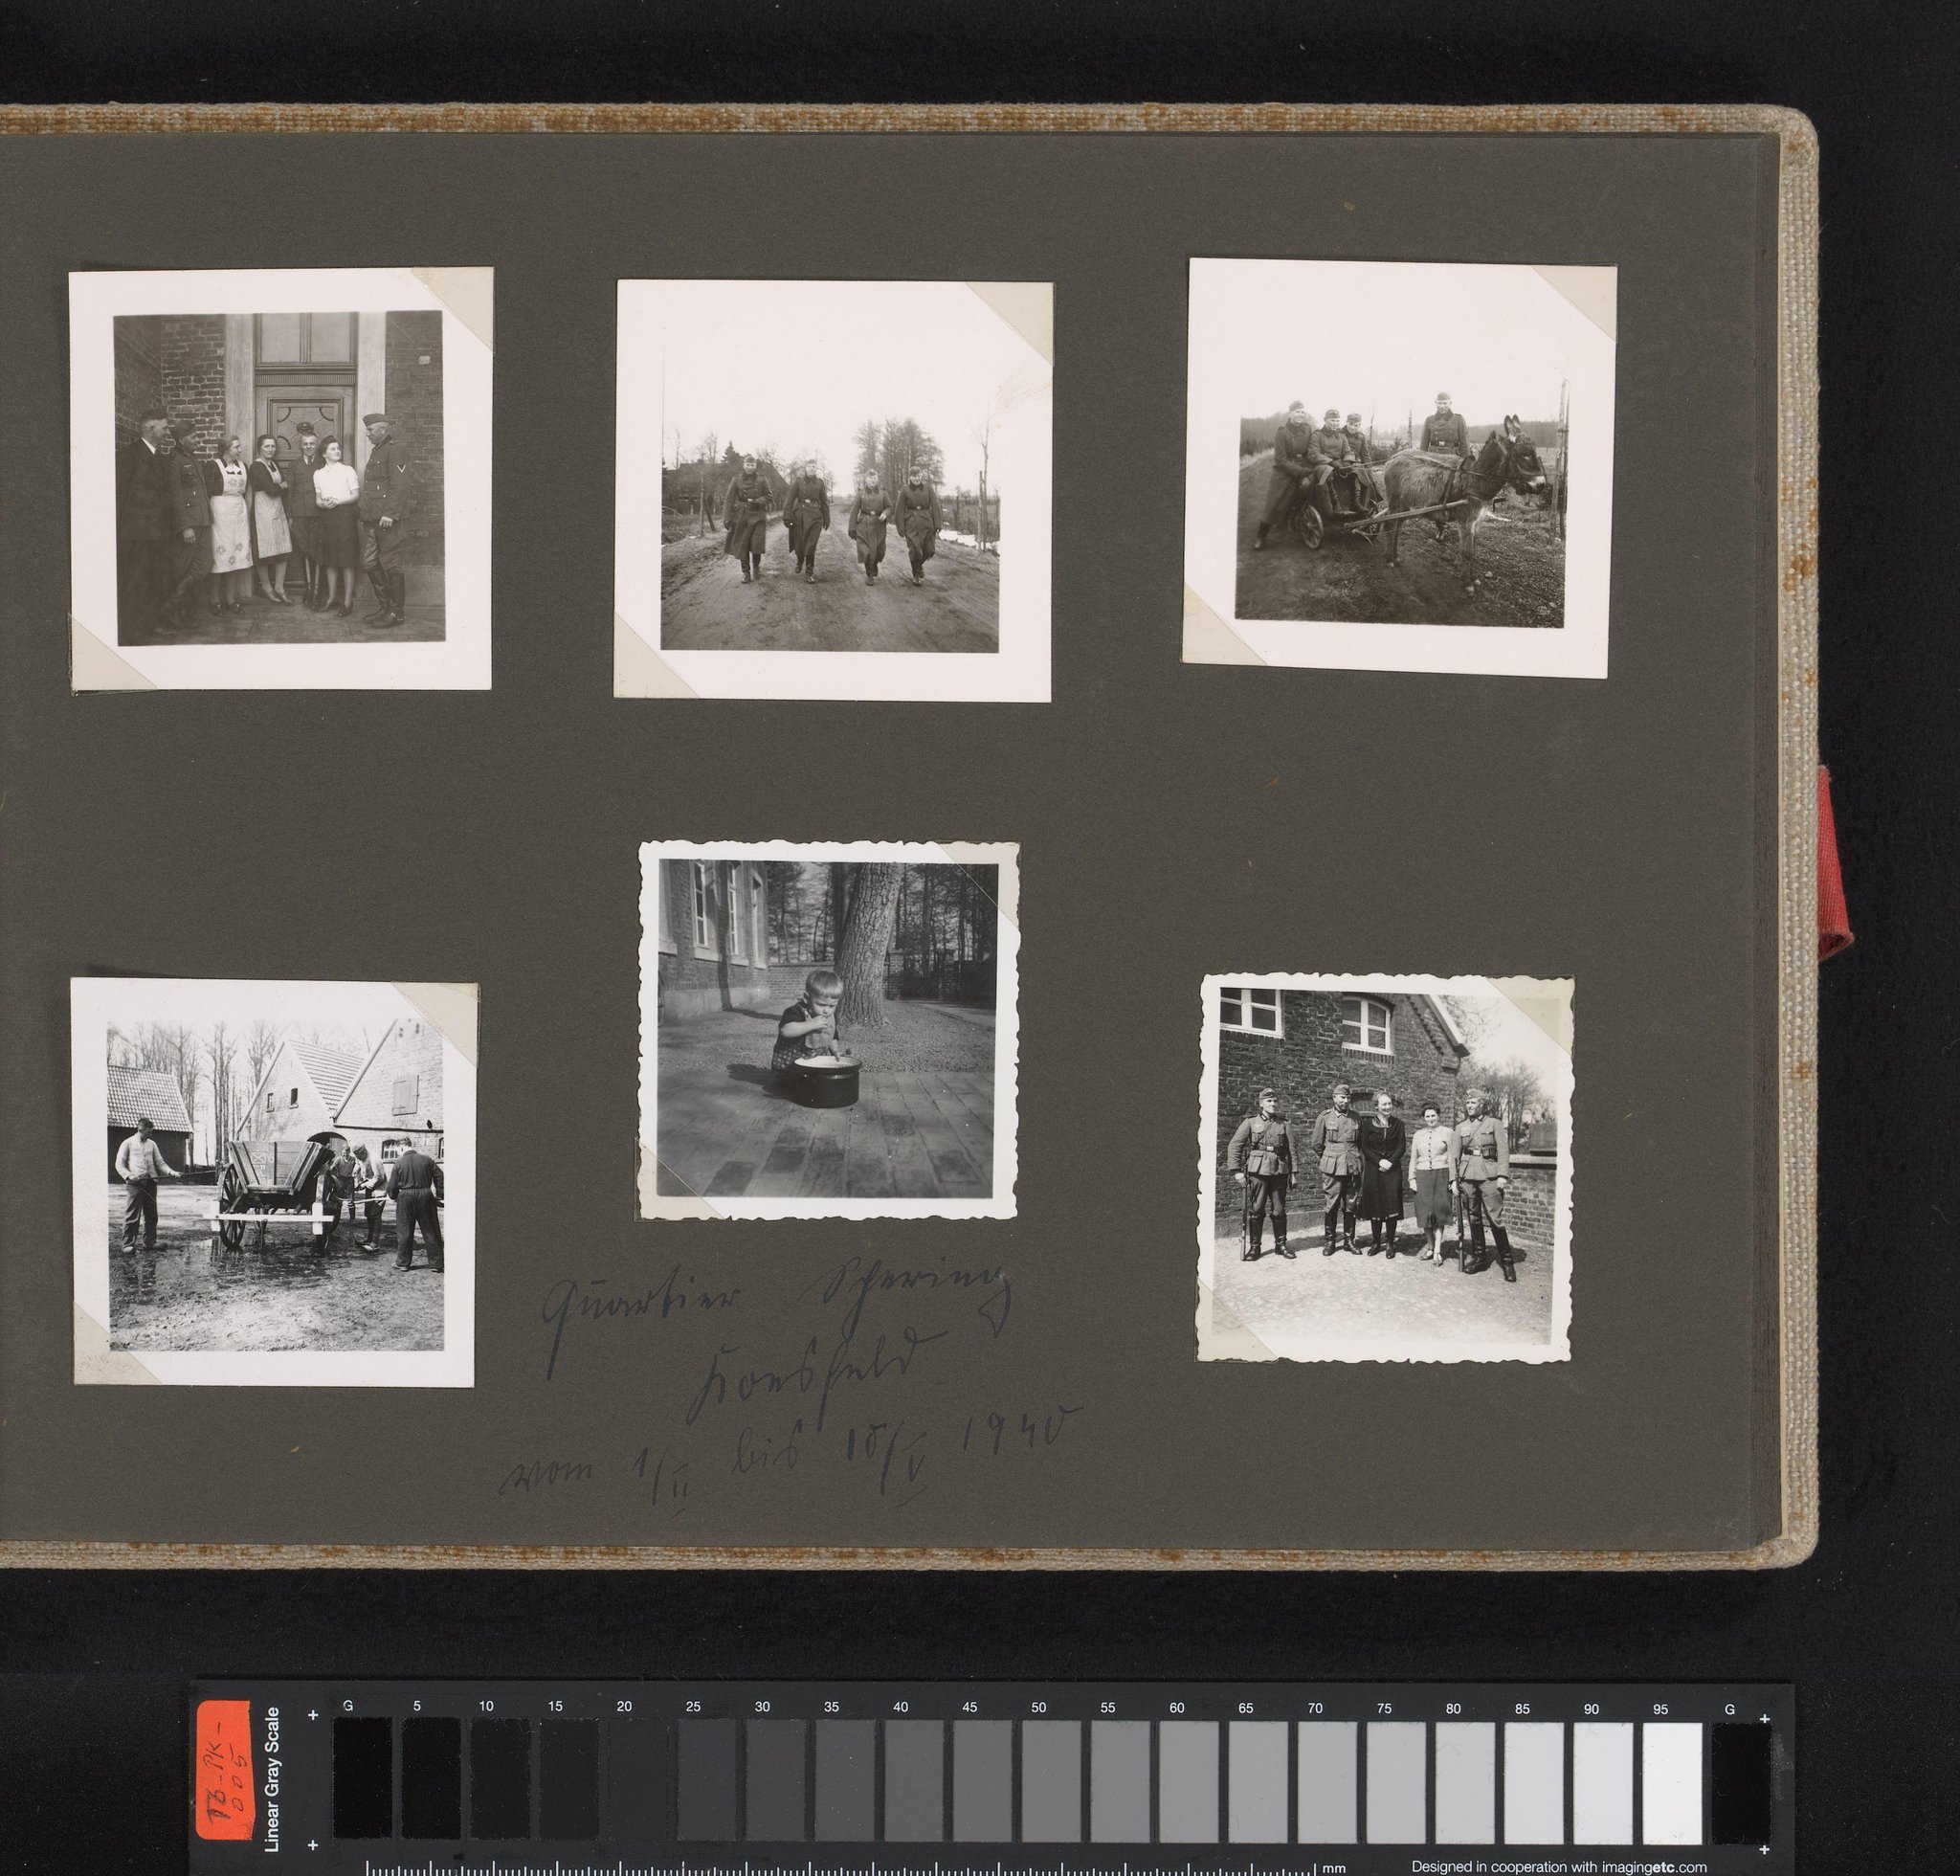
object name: album leaf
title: Werkzaamheden en groepsfoto's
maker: Anonymous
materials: cardboard, photographic support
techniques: gelatin silver print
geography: germany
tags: the company, the unit, the troop ~ military service, military training, germany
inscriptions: inscription: ‘... vom 1/II bis 10/V 1940’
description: Albumblad met zes foto's van werkzaamheden op het land en enkele groepsfoto's van de militairen met vrouwen, februari-mei 1940. Onderdeel van de fotoalbum van de Wehrmacht 1938-1941.